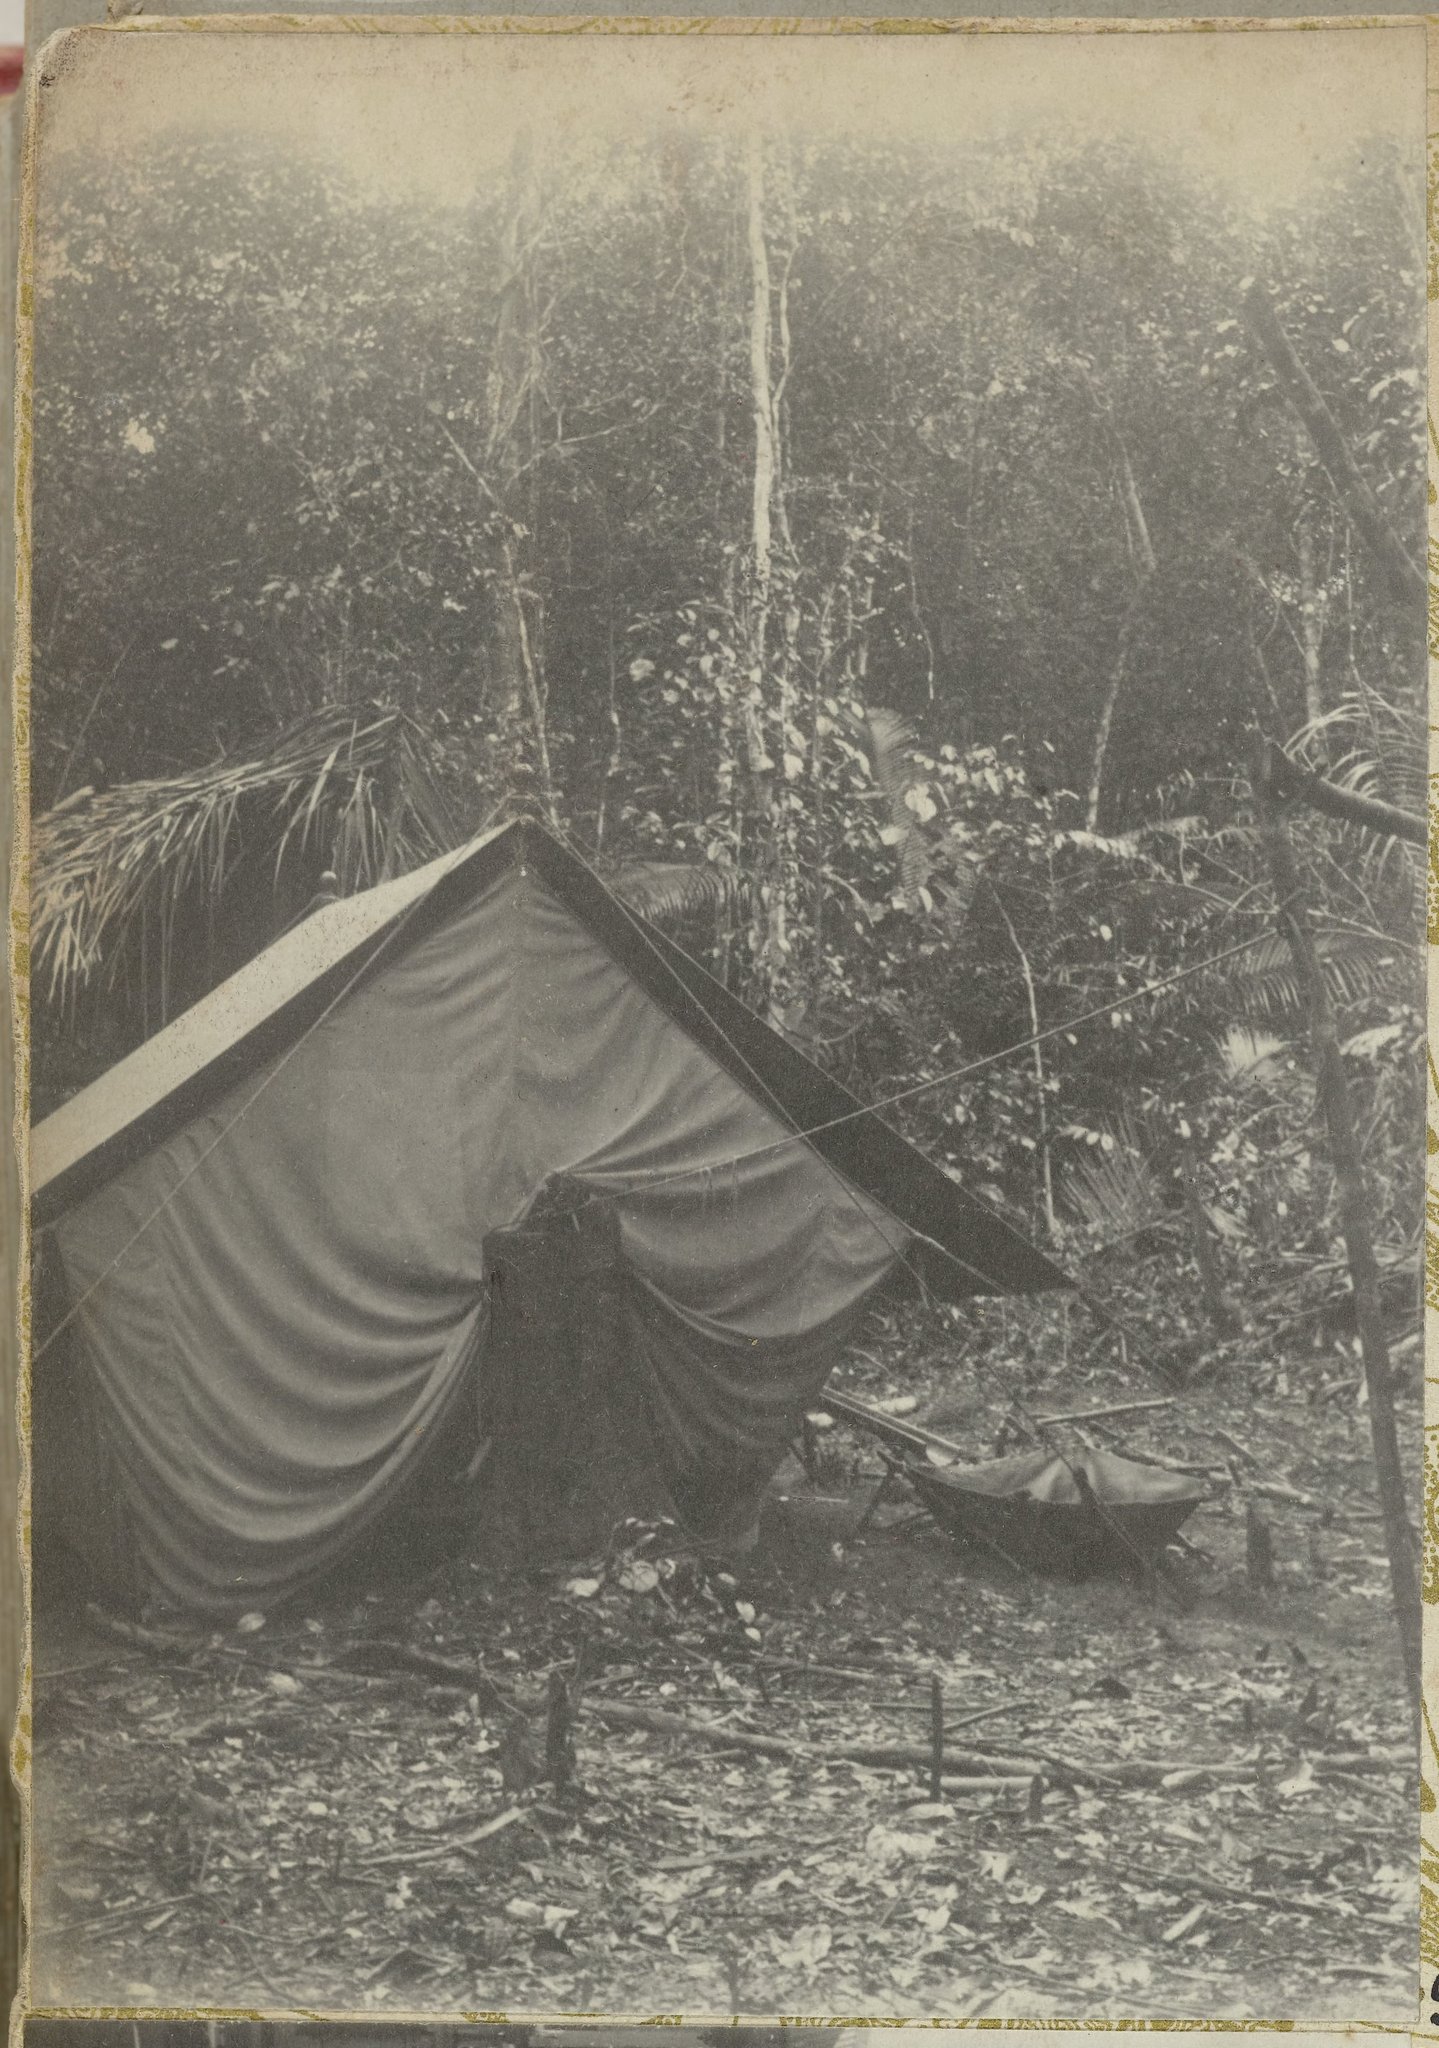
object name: photograph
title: Meetkamp met muskietentent aan de Saramaccakreek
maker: hendrik doijer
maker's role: engineer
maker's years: 1863-1925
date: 1903-1910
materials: photographic support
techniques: gelatin silver print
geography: suriname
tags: suriname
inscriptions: inscription: ‘9.’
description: Een tent overspannen met een muskietennet, in het meetkamp in het oerwoud aan de Kleine Saramacca Rivier (Saramaccakreek). Onderdeel van het fotoalbum Souvenir de Voyage (deel 1), over het leven van de familie Doijer in en rond de plantage Ma Retraite in Suriname in de jaren 1903-1910.